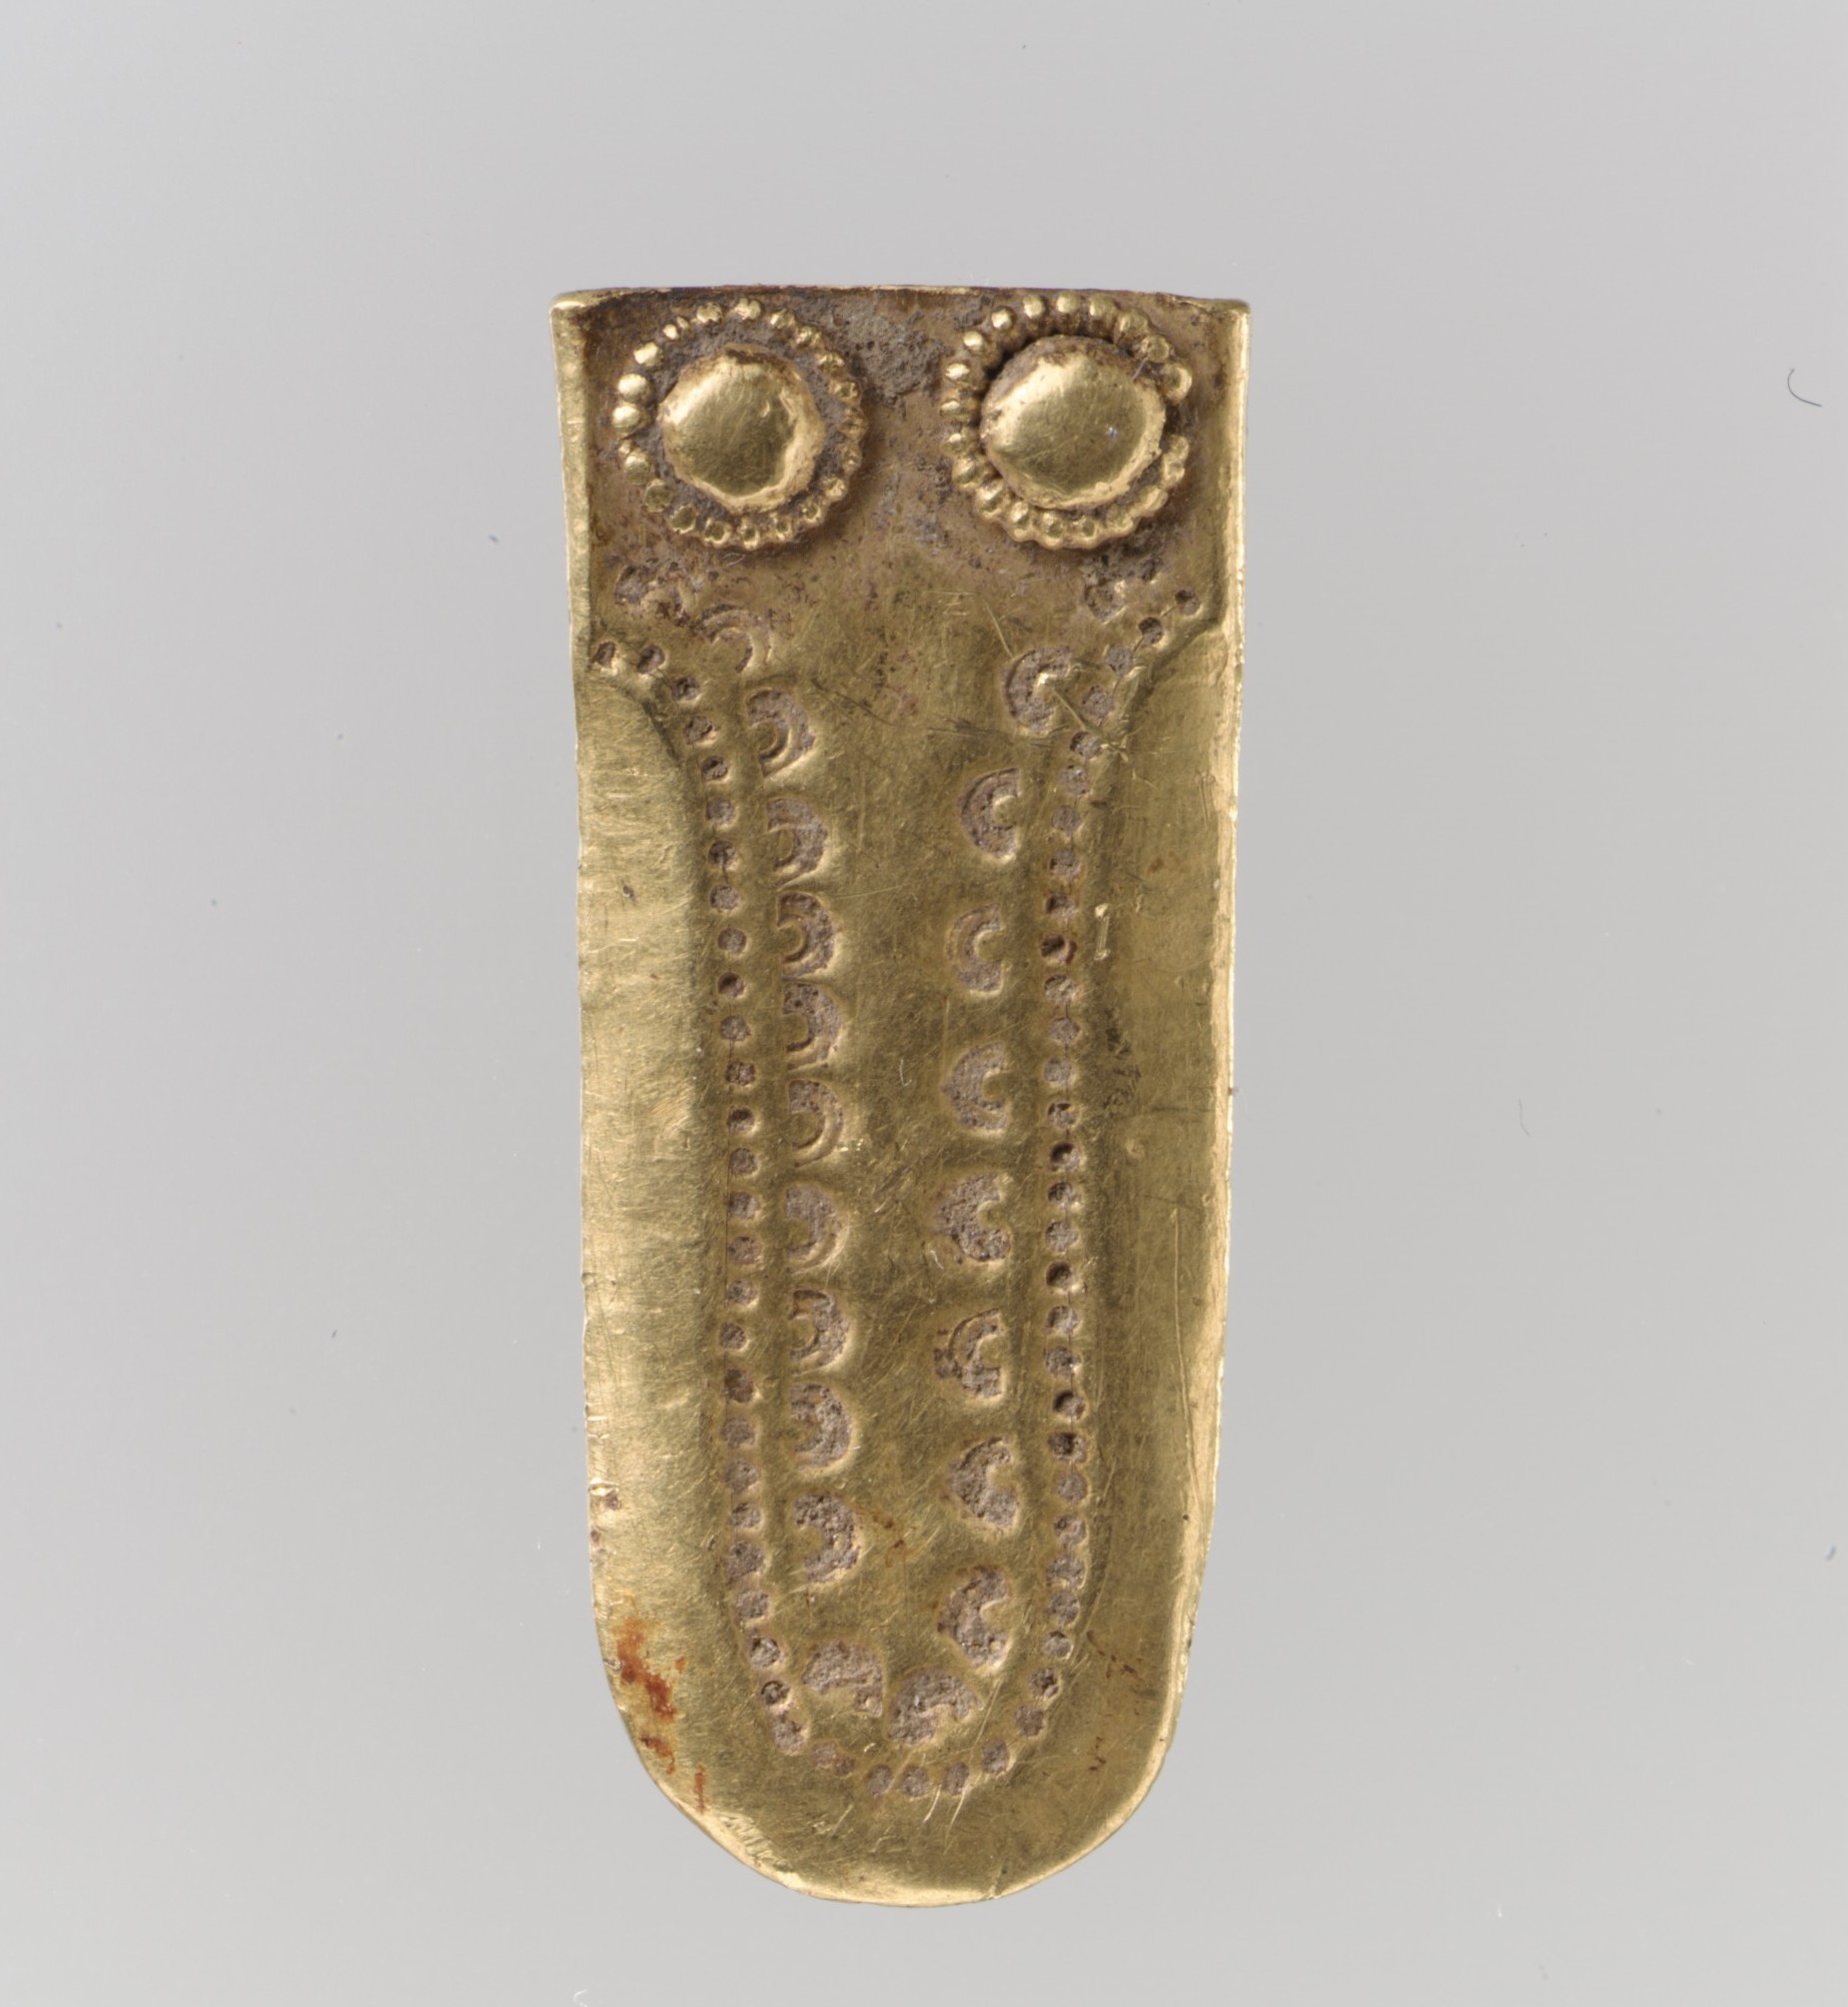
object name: strap end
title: Gold Strap End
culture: langobardic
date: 600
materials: gold, silver